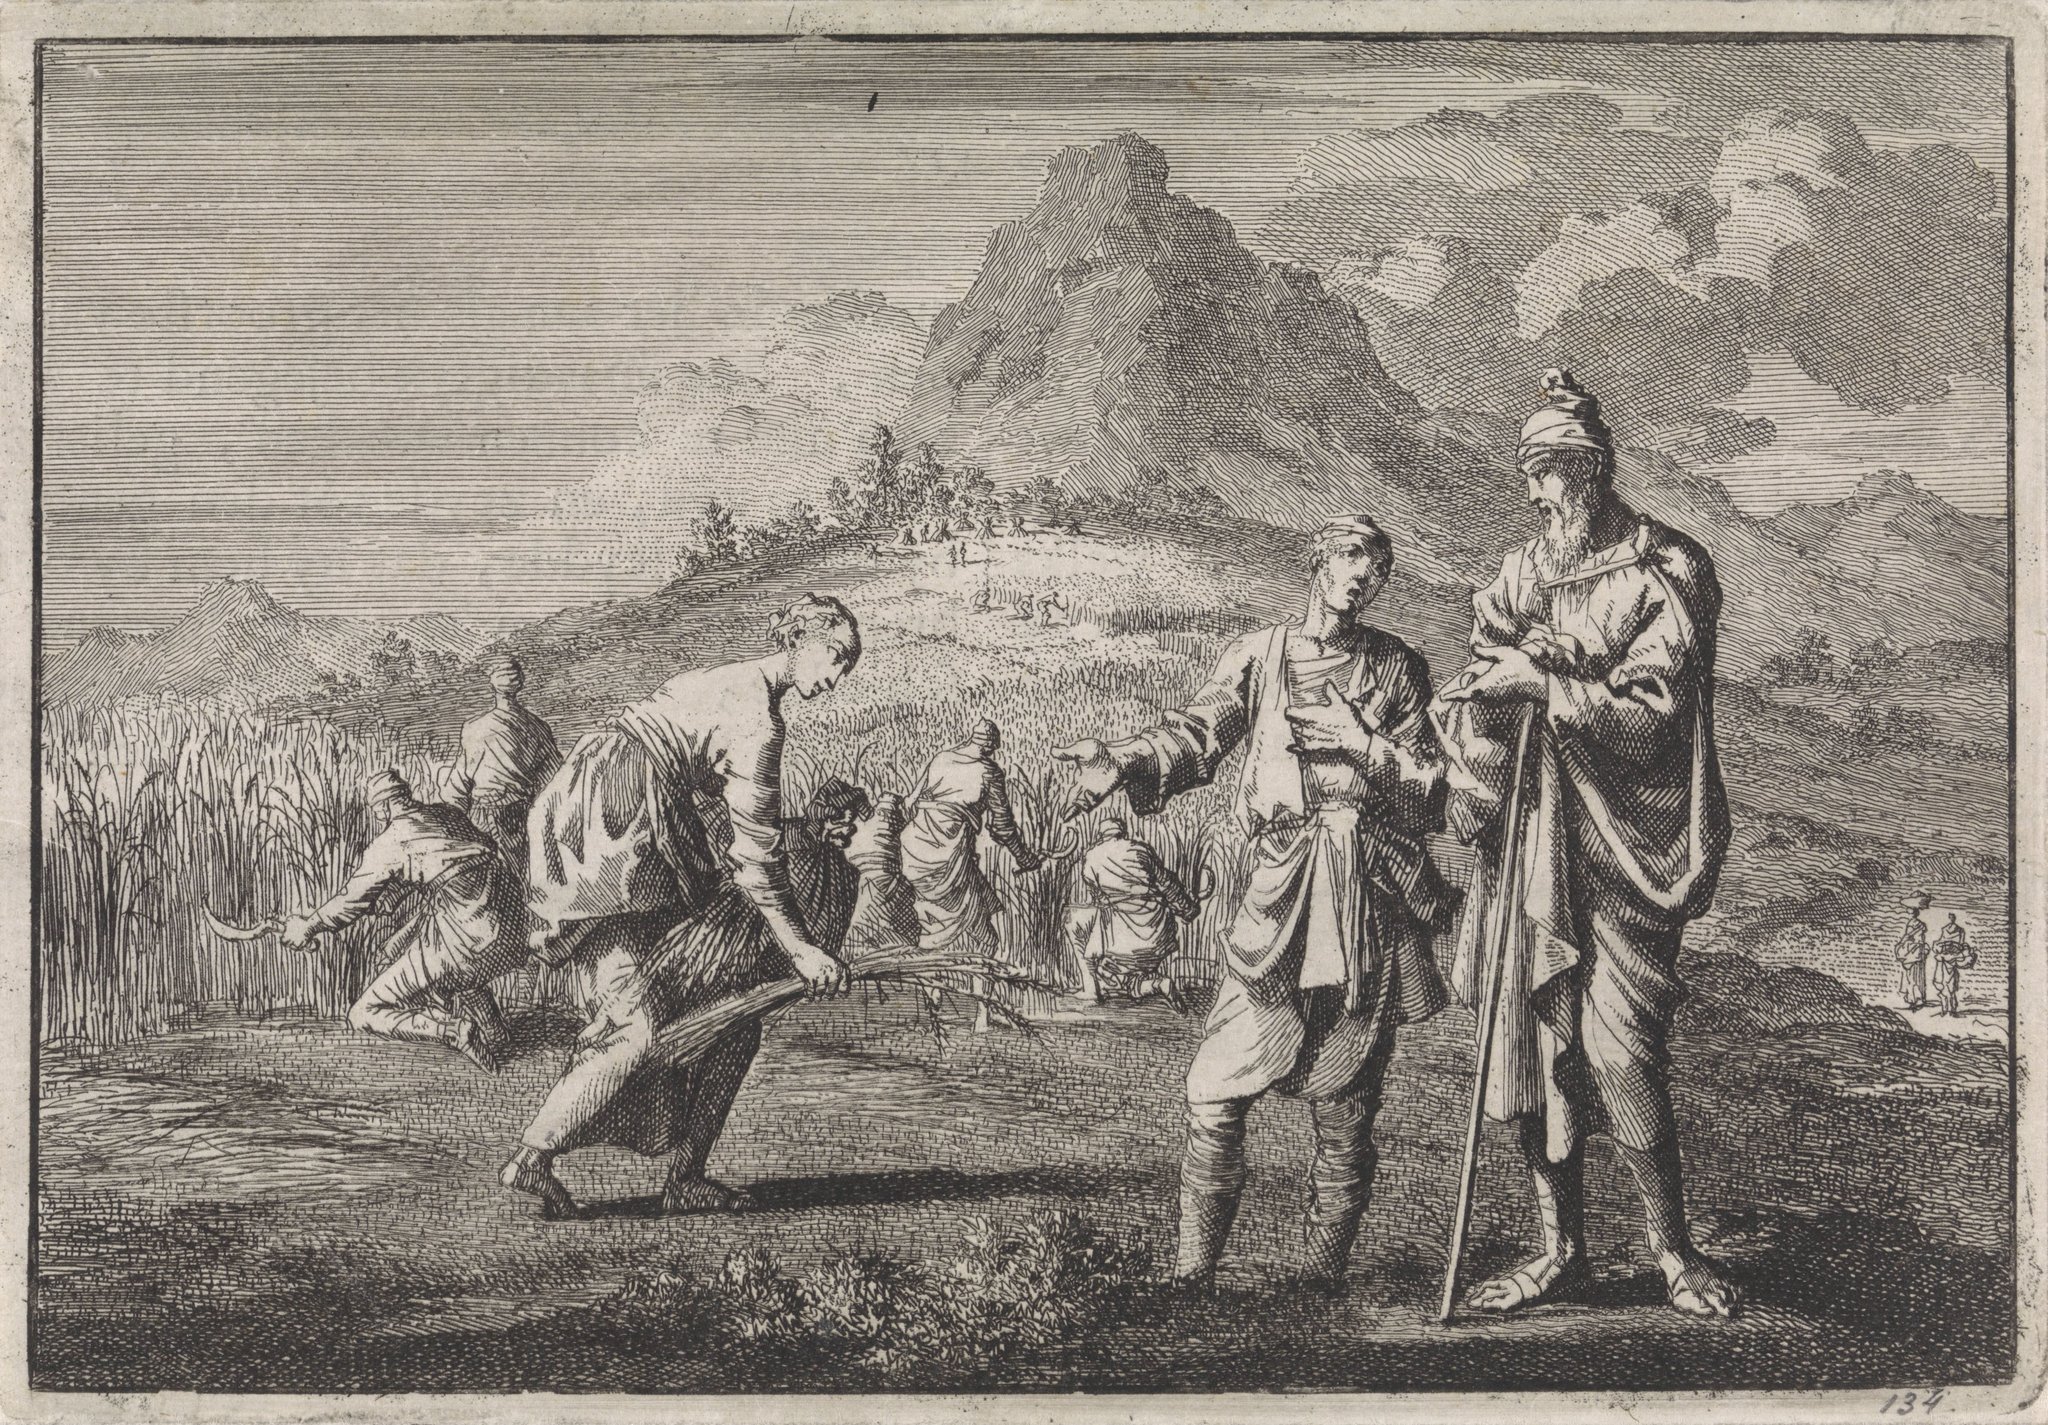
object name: print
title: Boaz ondervraagt zijn opzichter over Ruth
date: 1704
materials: paper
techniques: etching, letterpress printing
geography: amsterdam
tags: boaz questions his servant concerning ruth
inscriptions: collector's mark: Lugt 2228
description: Prent opgenomen in: Josephus, Flavius. Alle de Werken, 2 delen. Amsterdam: Pieter Mortier, 1704, dl. 1, p. 124.